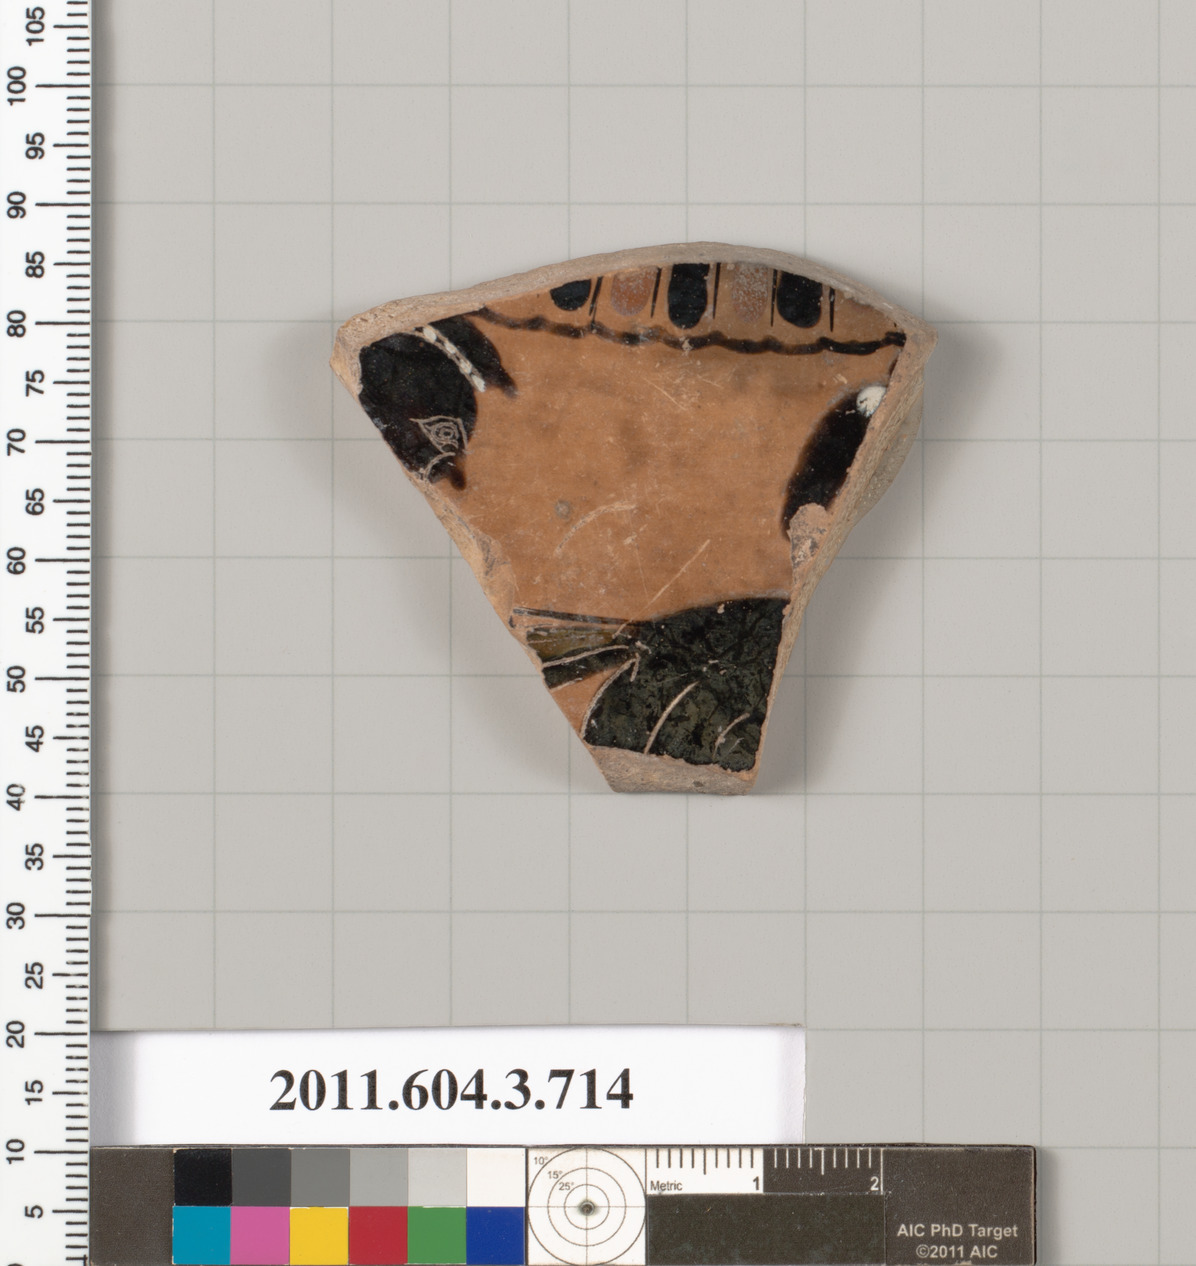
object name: hydria fragment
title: Terracotta fragment of a hydria (water jar)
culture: greek, attic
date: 525-501 BCE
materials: terracotta